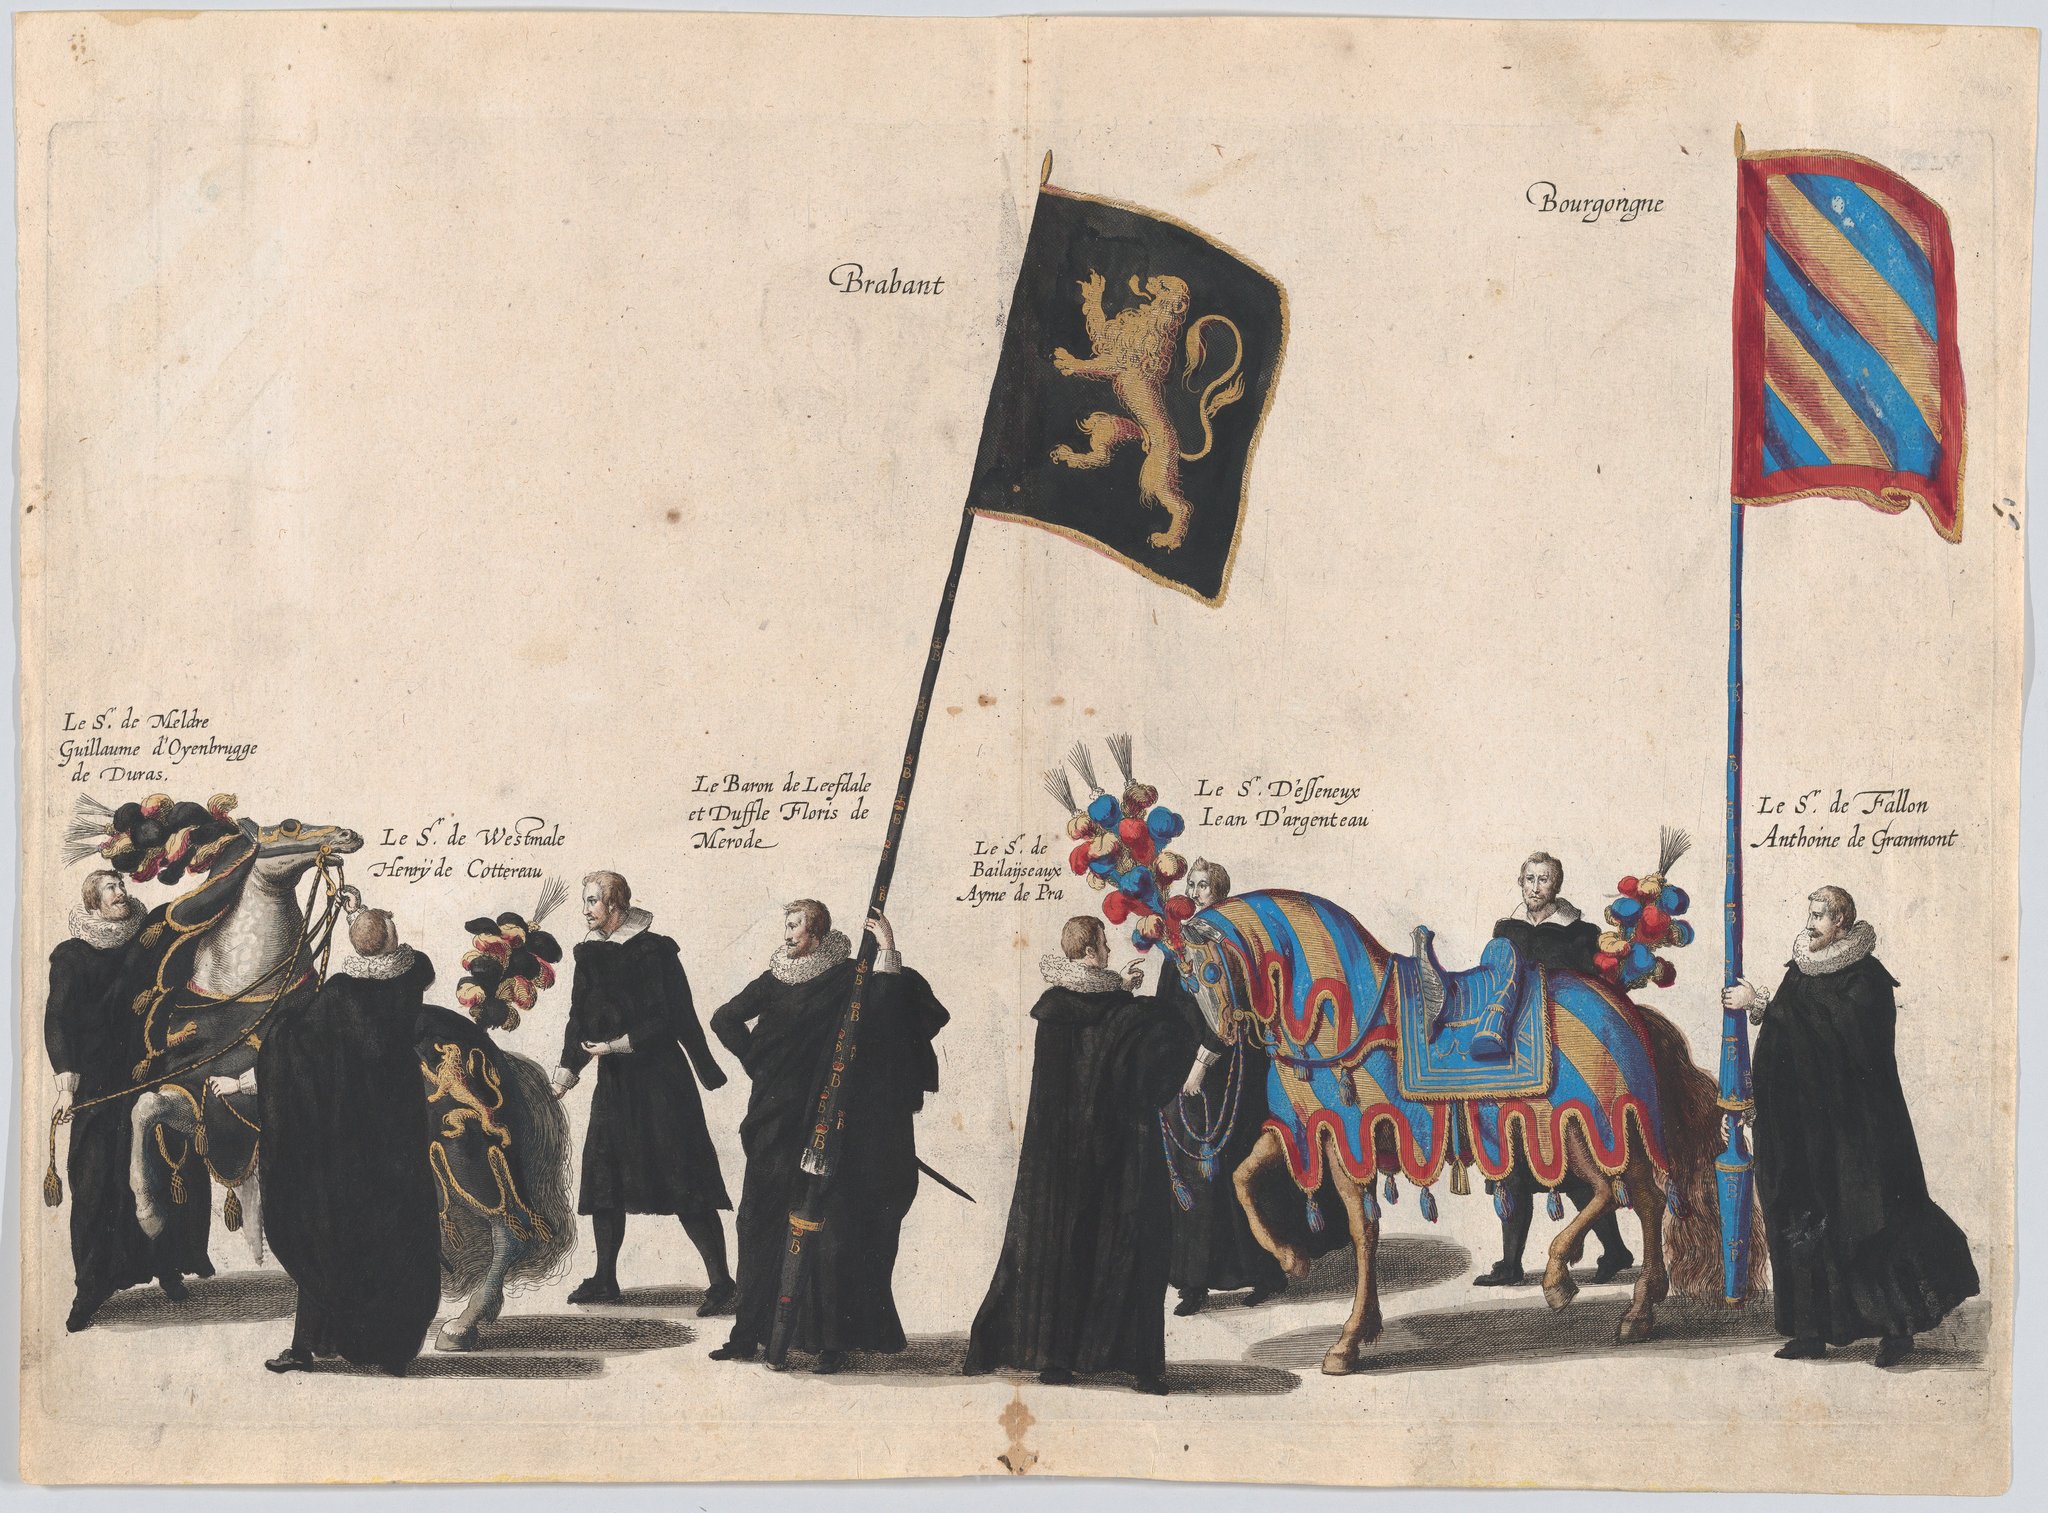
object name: print, fete, ornament architecture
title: Plate 45: Men with heraldic flags and horses from the House of Brabant and Burgundy marching in the funeral procession of Archduke Albert of Austria; from 'Pompa Funebris ... Alberti Pii'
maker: cornelis galle (i)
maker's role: artist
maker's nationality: netherlandish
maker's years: 1576-1650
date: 1623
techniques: etching, hand coloring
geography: brussels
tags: men,horses,flags